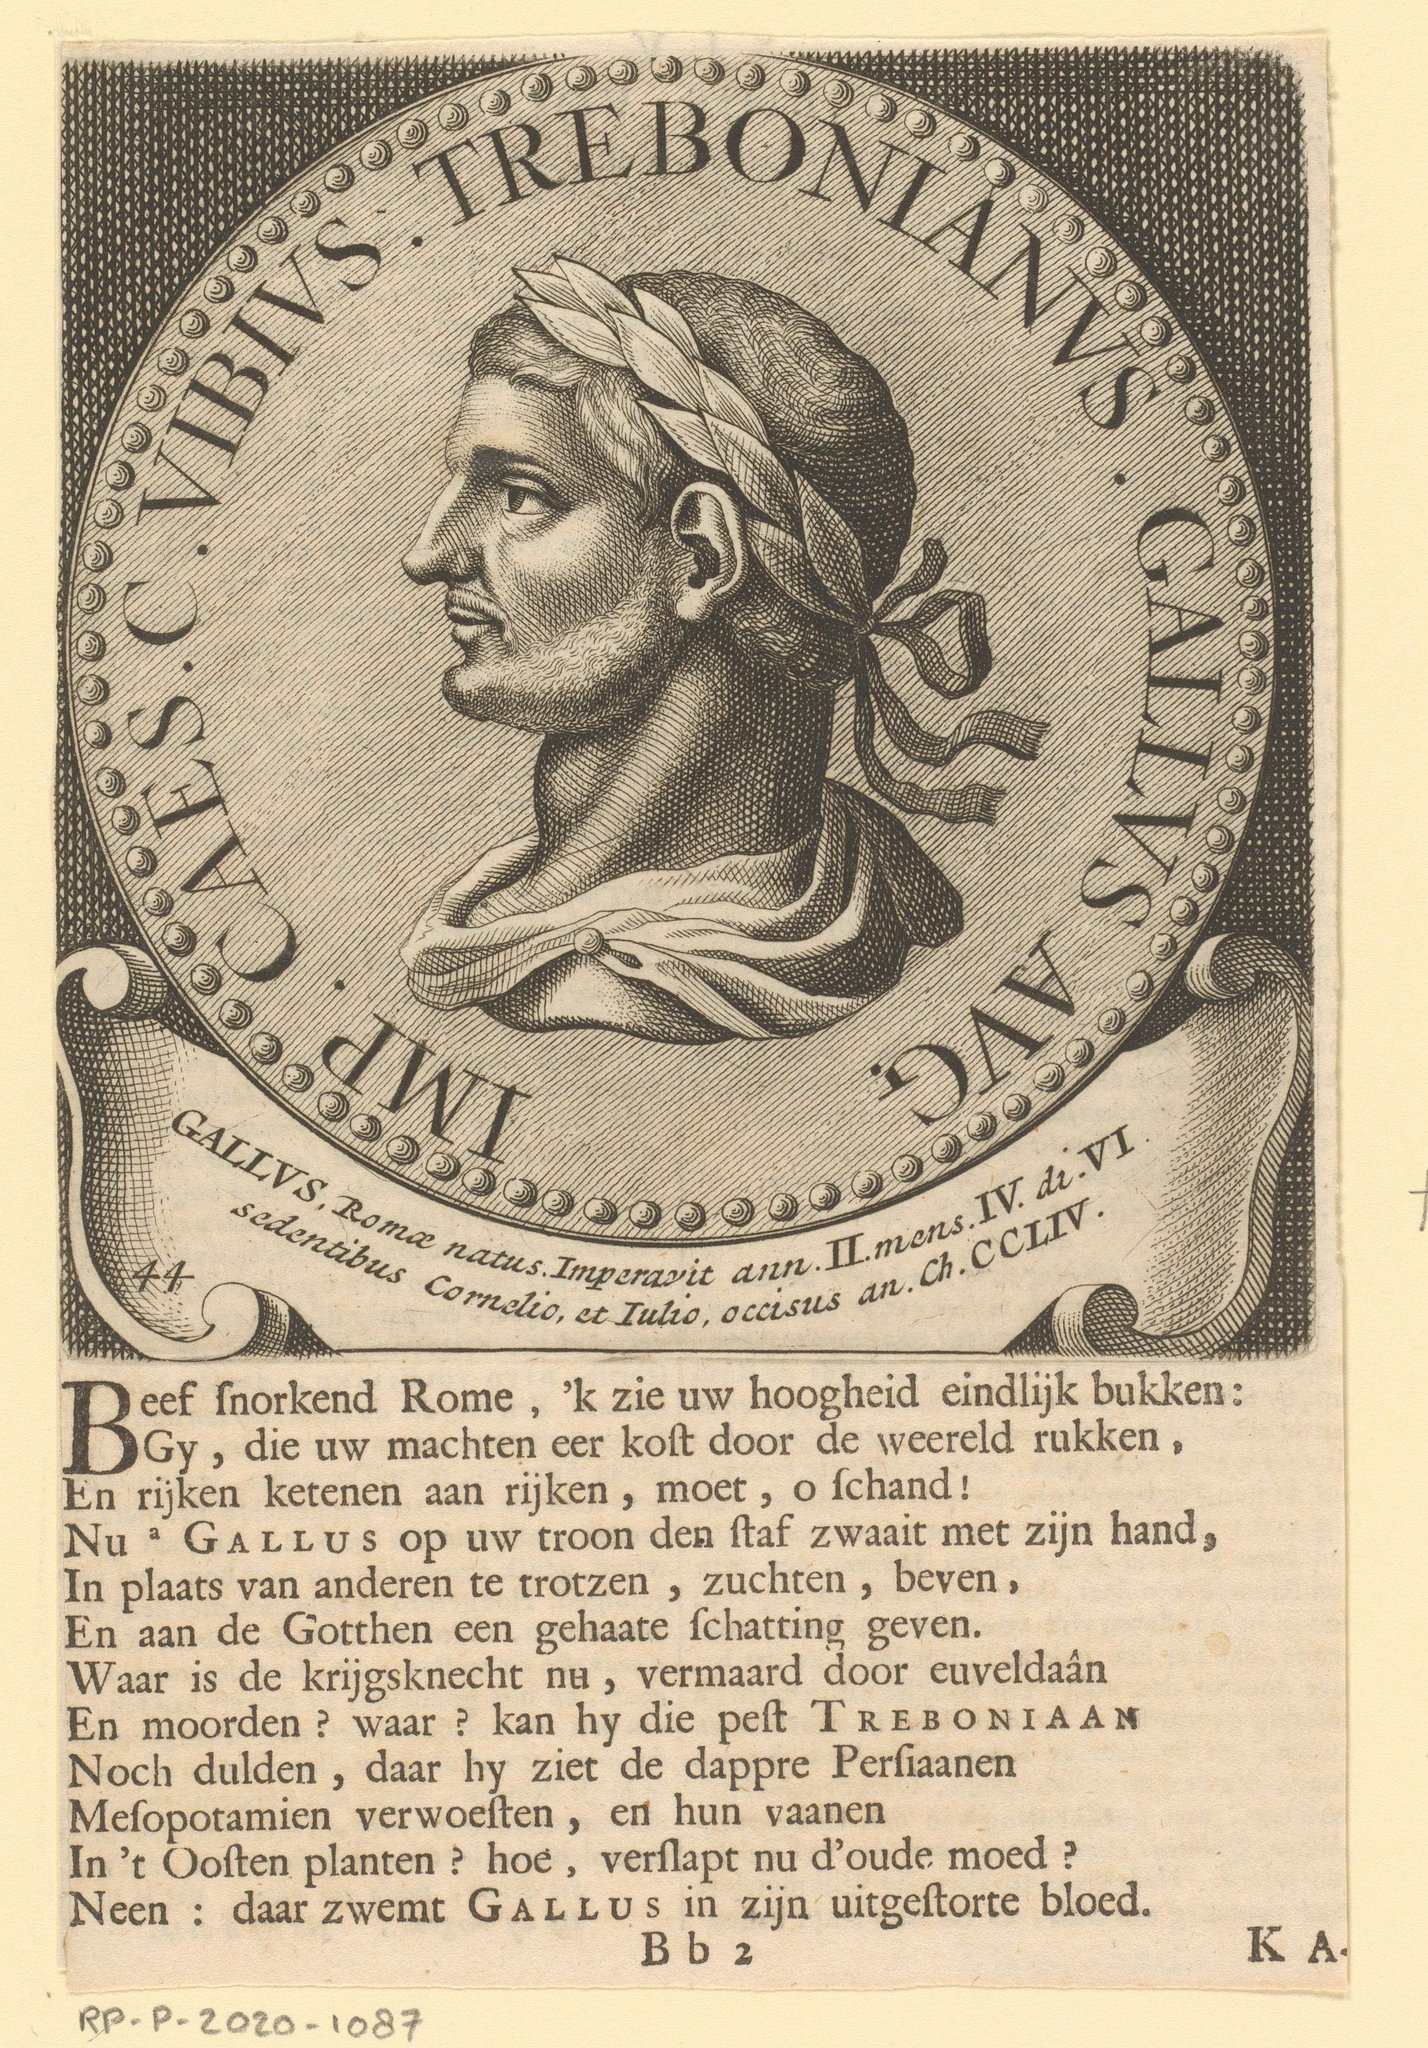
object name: print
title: Gallus, Romae natus (...)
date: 1697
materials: paper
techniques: engraving, etching, letterpress printing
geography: utrecht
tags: historical persons, emperor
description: Prent uit: Bogaert, Abraham. De Roomsche monarchy, vertoont in de muntbeelden der westersche en oostersche keizeren (...). Utrecht: François Halma en Willem van de Water, 1697, p. 195. Eerste staat verschenen in een grotere prent met twaalf portretten, gedateerd 1695.